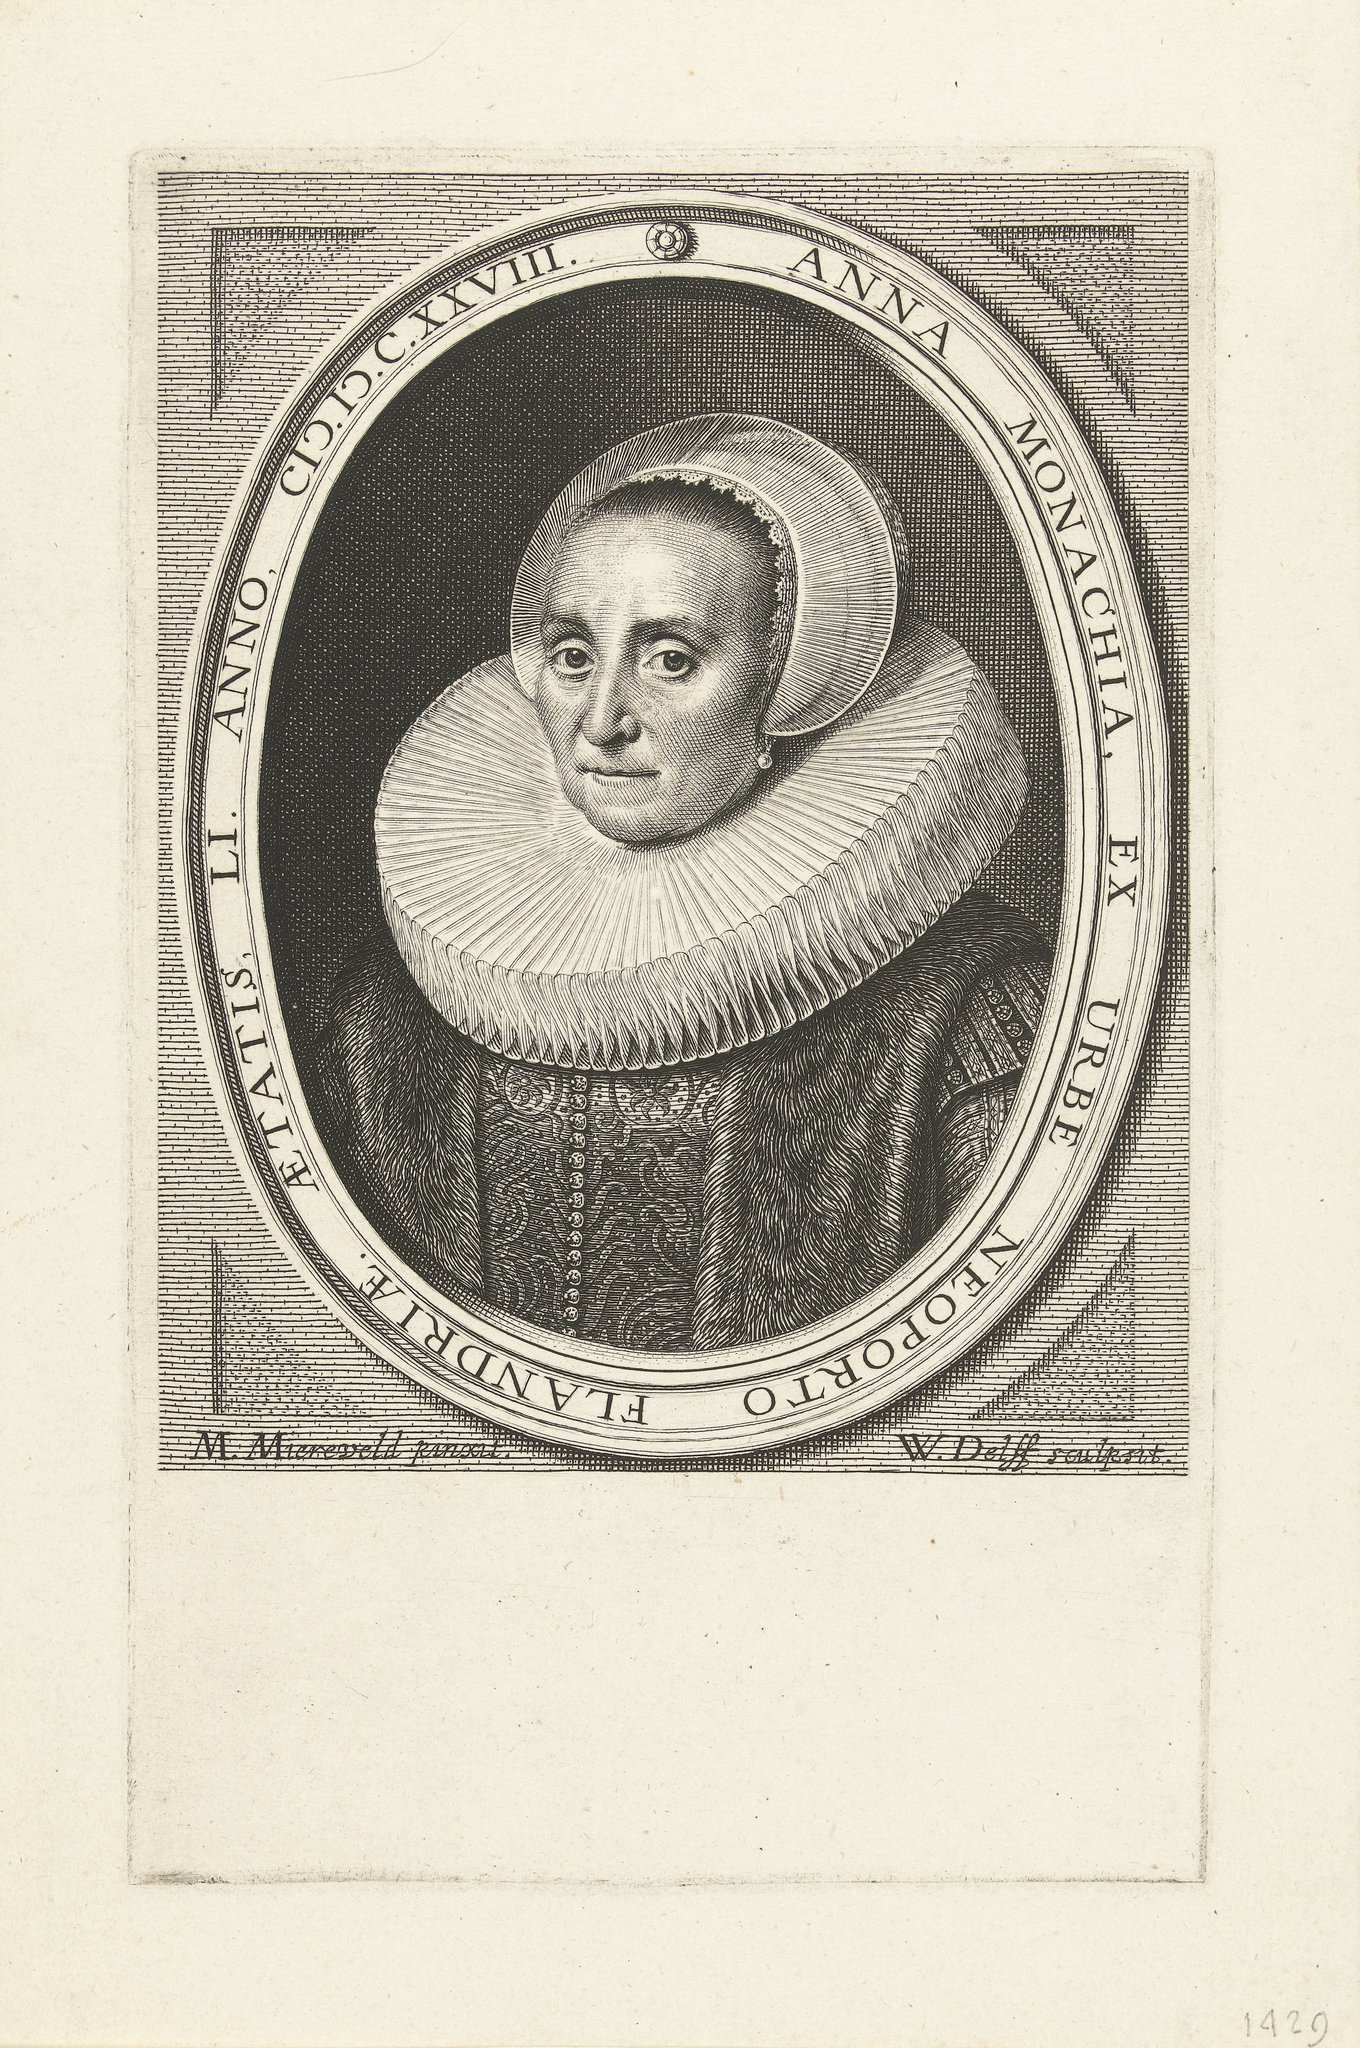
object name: print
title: Portret van Anna Monachia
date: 1628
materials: paper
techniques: engraving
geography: delft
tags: anna monachia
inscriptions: collector's mark: Lugt 240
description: Portret van Anna Monachia, borststuk met molenkraag en kanten muts, in ovale omlijsting met Latijns opschrift.